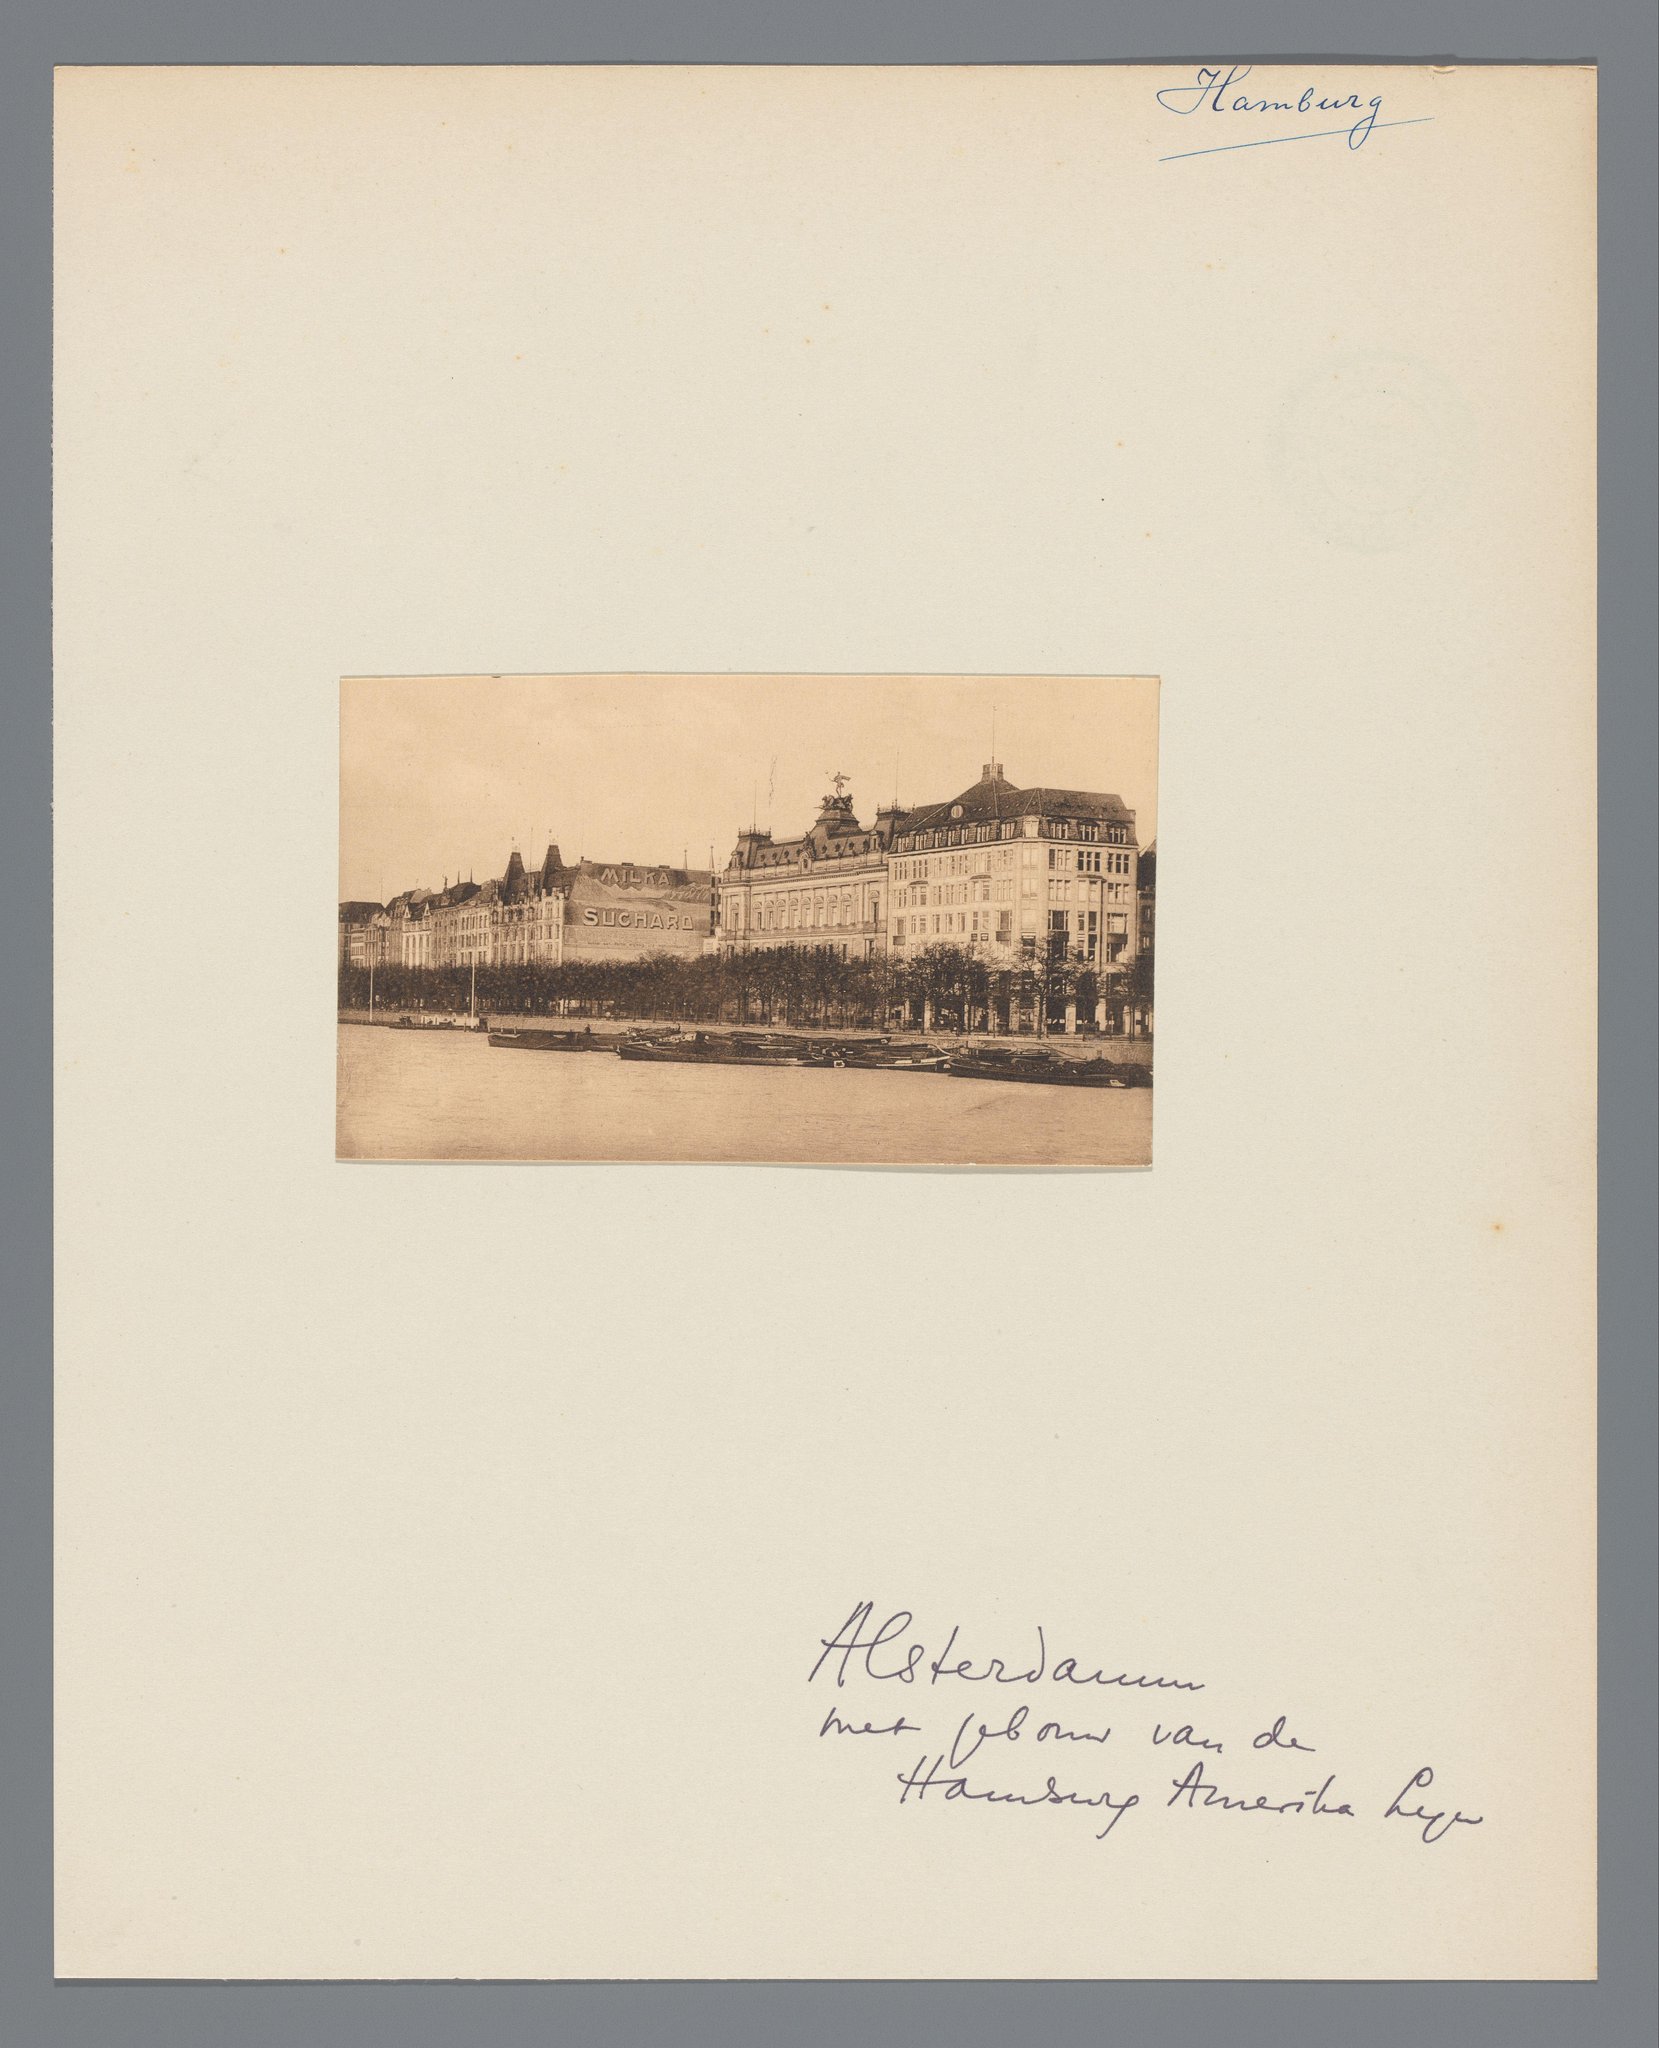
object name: photograph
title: Hamburg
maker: Anonymous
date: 1880-1920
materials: cardboard, photographic support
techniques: photograph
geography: hamburg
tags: hamburg